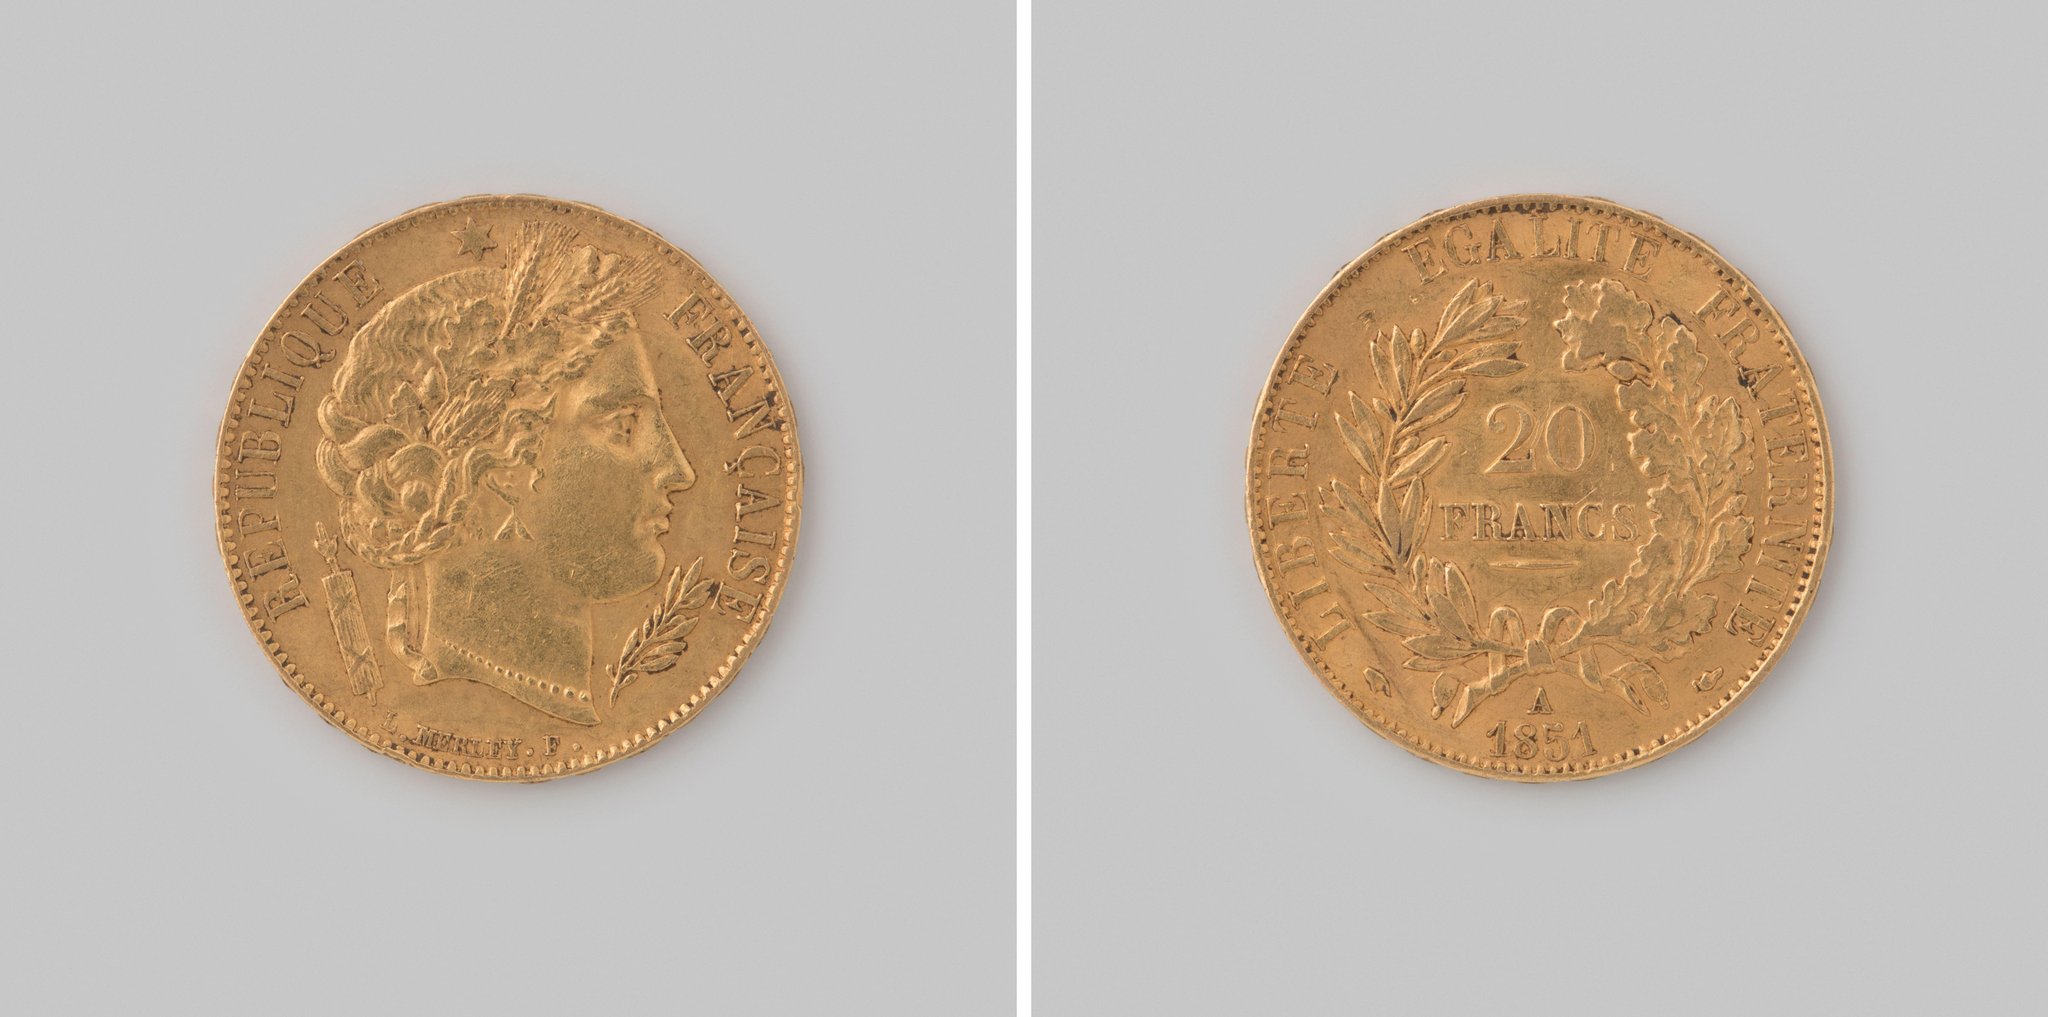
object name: coin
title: twintig francs uit Frankrijk, de Tweede Republiek, 1851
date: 1851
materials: gold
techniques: striking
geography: paris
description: Gouden munt. Voorzijde: portret van een vrouw met eikenkrans en diadeem naar rechts met linksonderr pijlenbundel met hand en rechtsonder korenaar. Keerzijde: binnen twee samengebonden takken waarde-aanduiding in twee regels. Onderaan de letter A [=Parijs], waaronder jaartal. Opliggend randschrift.